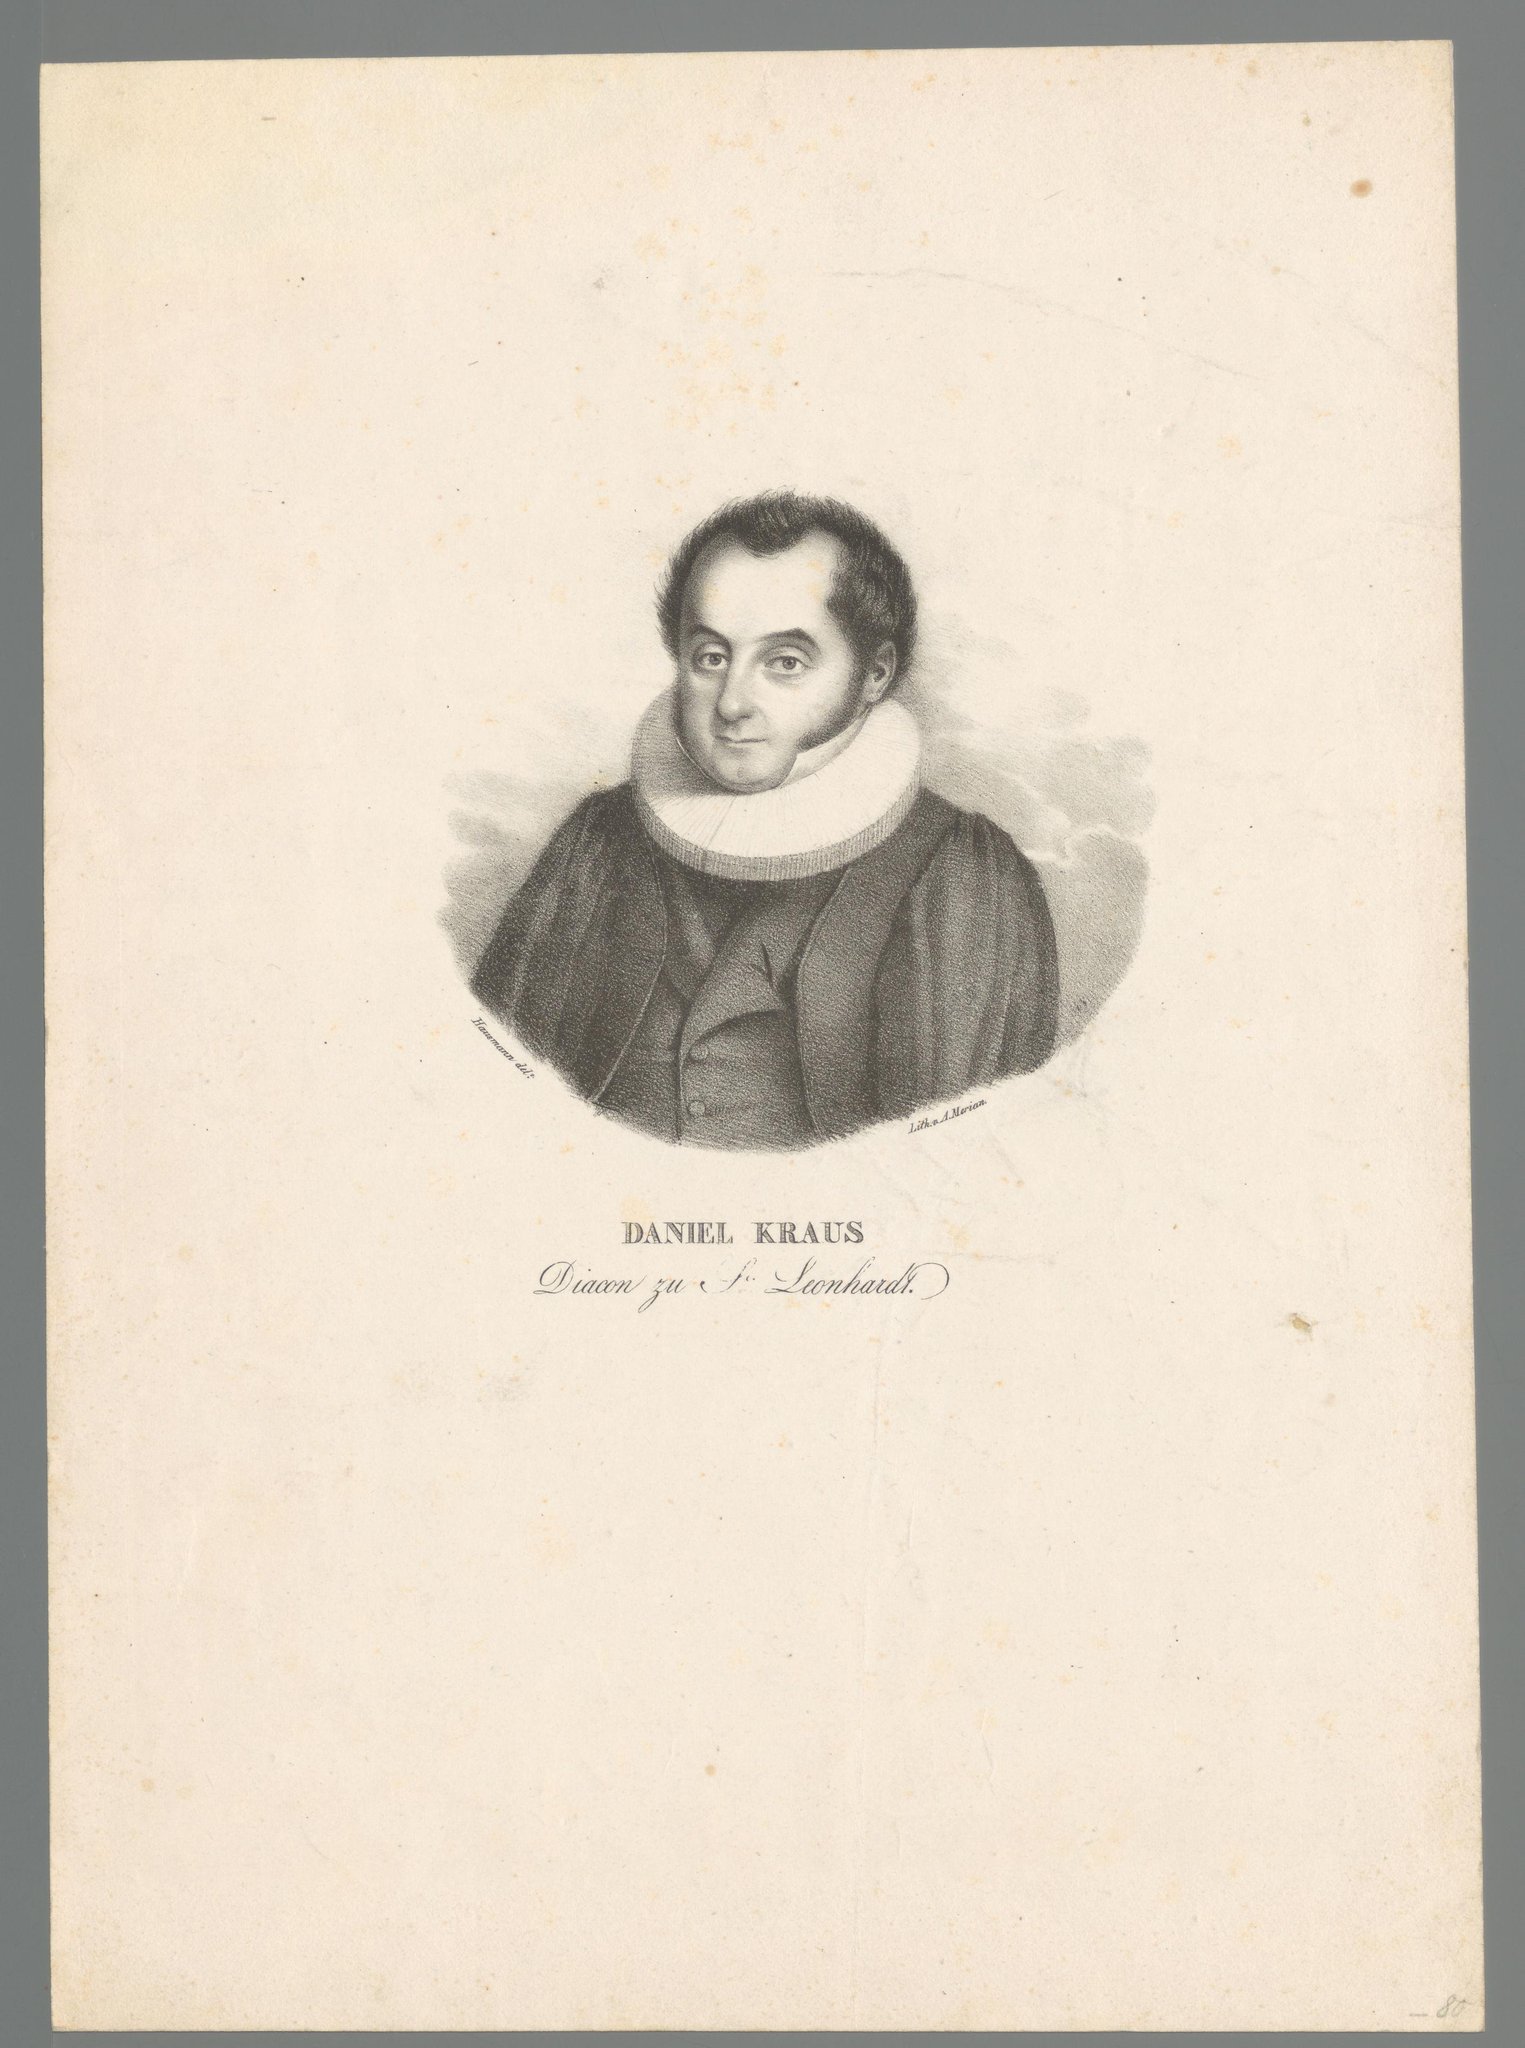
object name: print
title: Portret van Daniel Kraus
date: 1820-1860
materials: paper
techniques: lithograph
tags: historical persons, organization, functionaries and dignitaries in churches and in related institutions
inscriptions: collector's mark: Lugt 2228